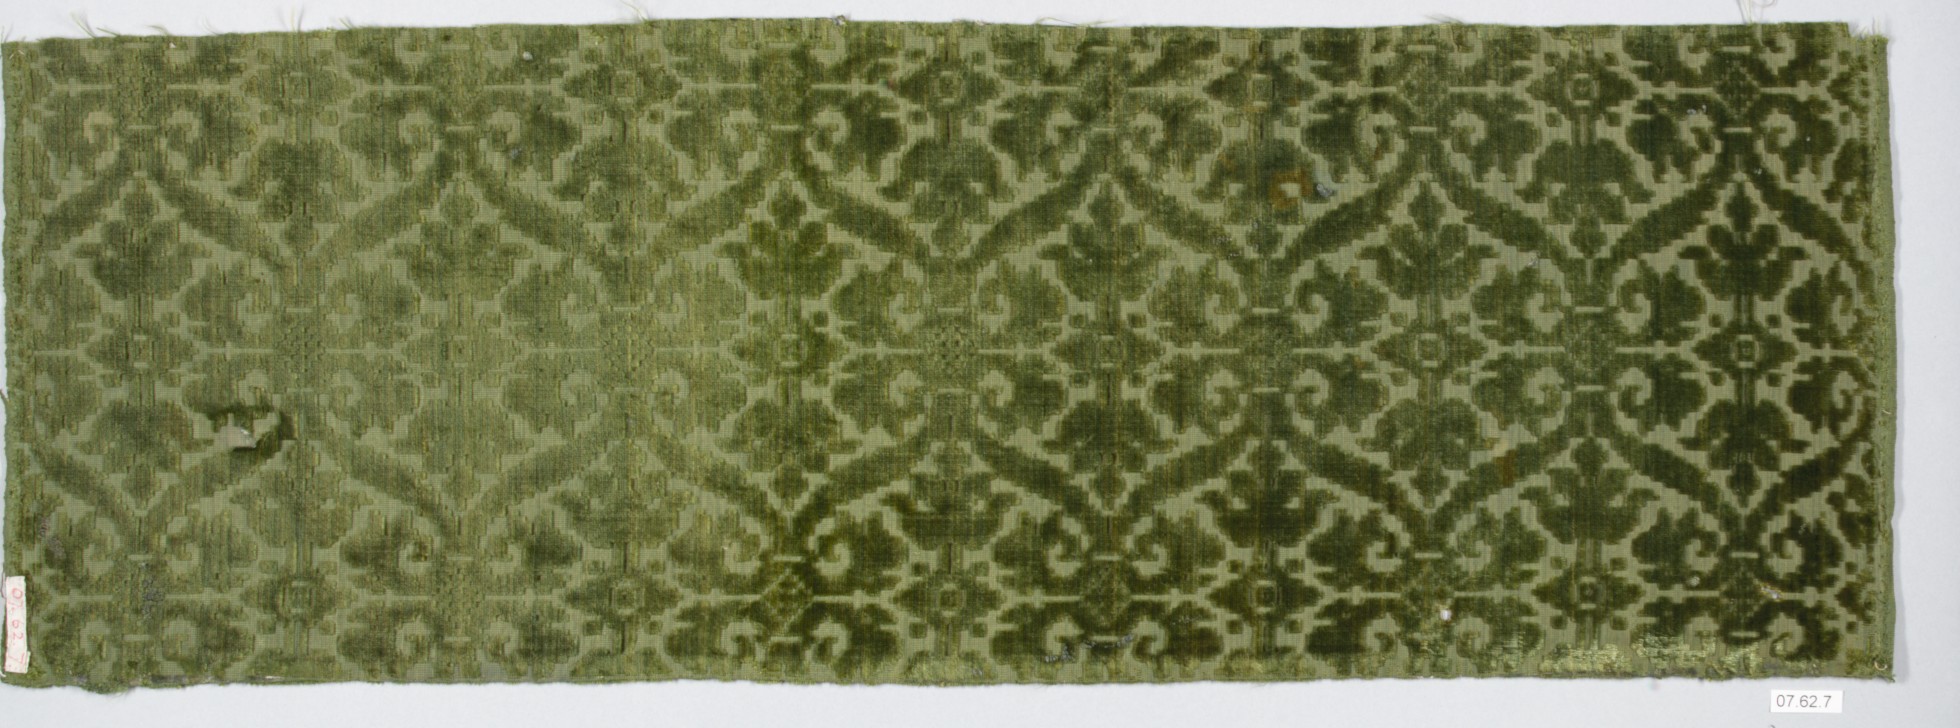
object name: piece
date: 1501-1600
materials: silk